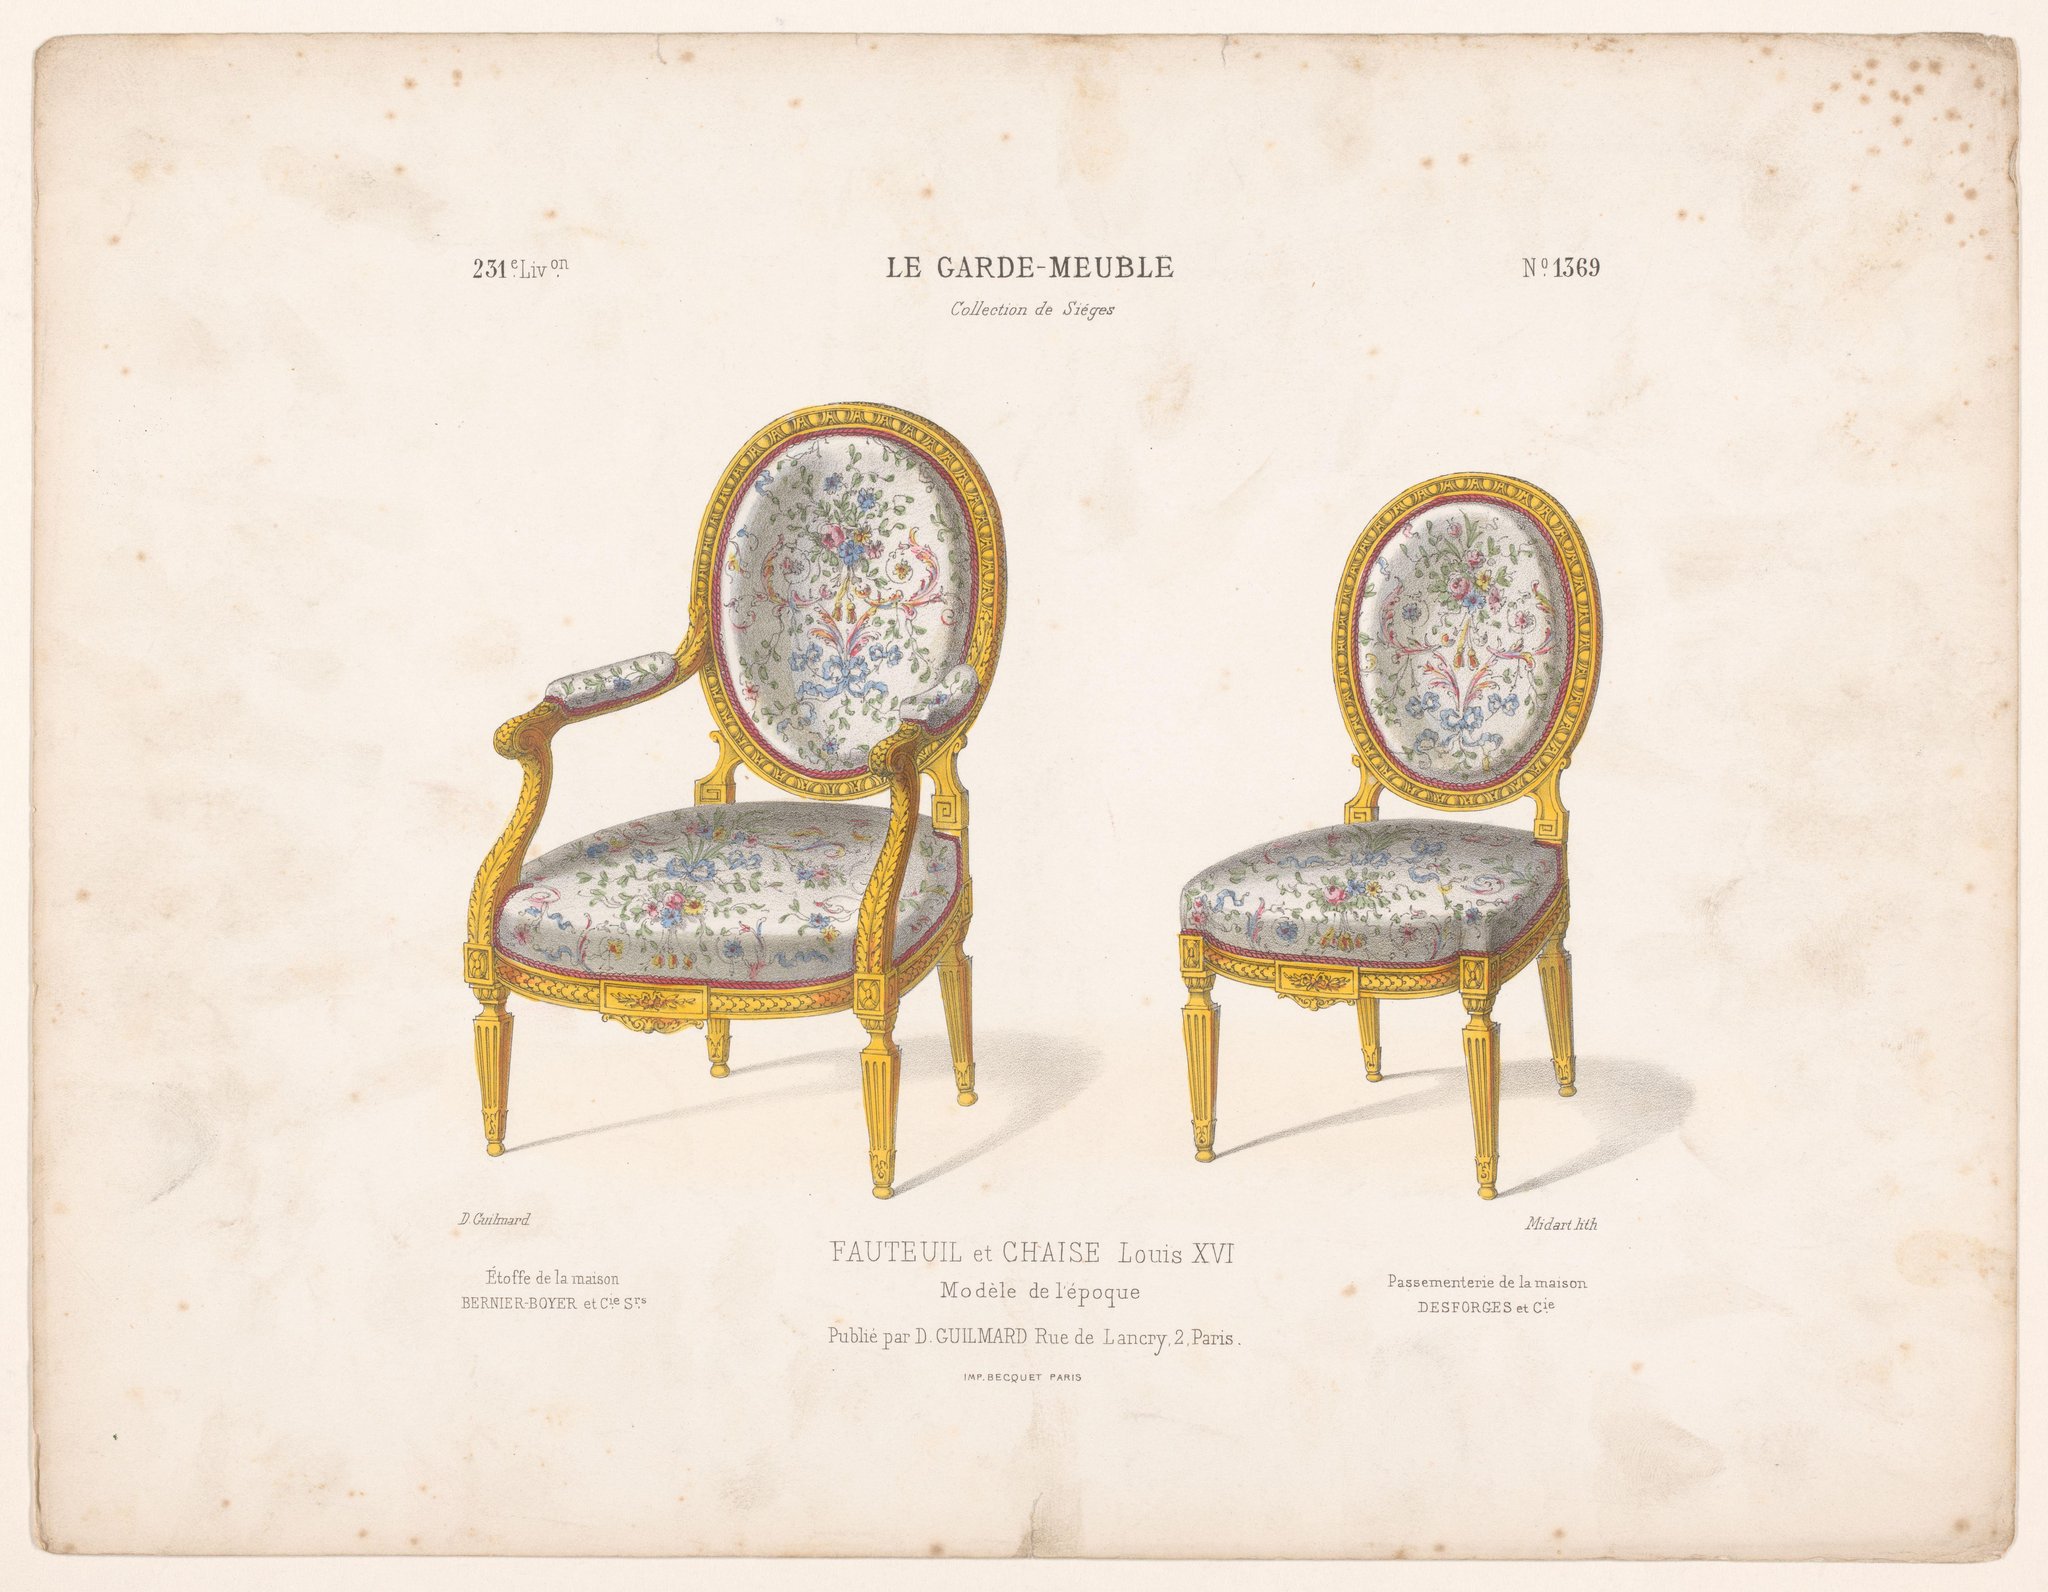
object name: print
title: Fauteuil en stoel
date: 1839-1885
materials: paper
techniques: hand coloring, lithograph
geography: paris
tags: seating furniture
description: Ieder Livraison in de serie Le Garde-Meuble bevat negen platen: drie 'sièges' (zitmeubels), drie 'meubles' (diverse meubels zoals tafels en kasten) en drie 'tentures' (gordijnen en draperieën).